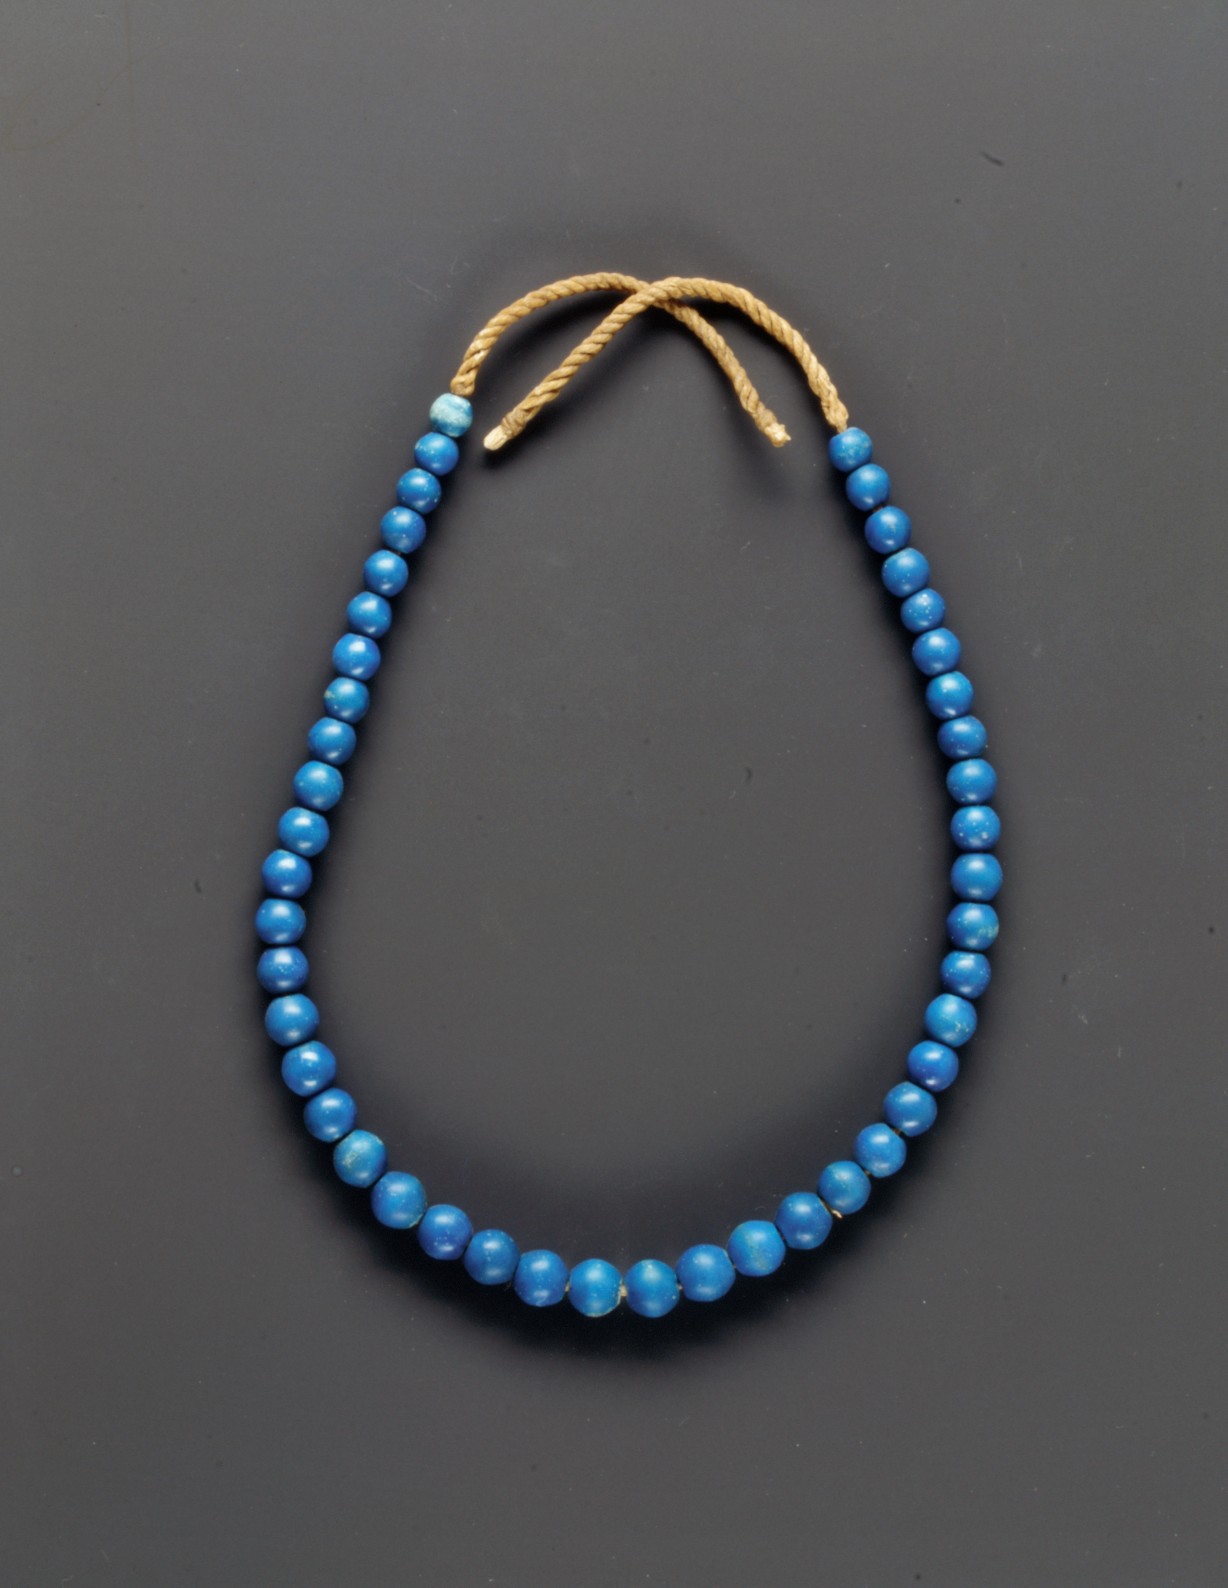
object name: necklace, wah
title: Necklace of Graduated Ball Beads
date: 1981-1975 BCE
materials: cord, faience, linen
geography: egypt